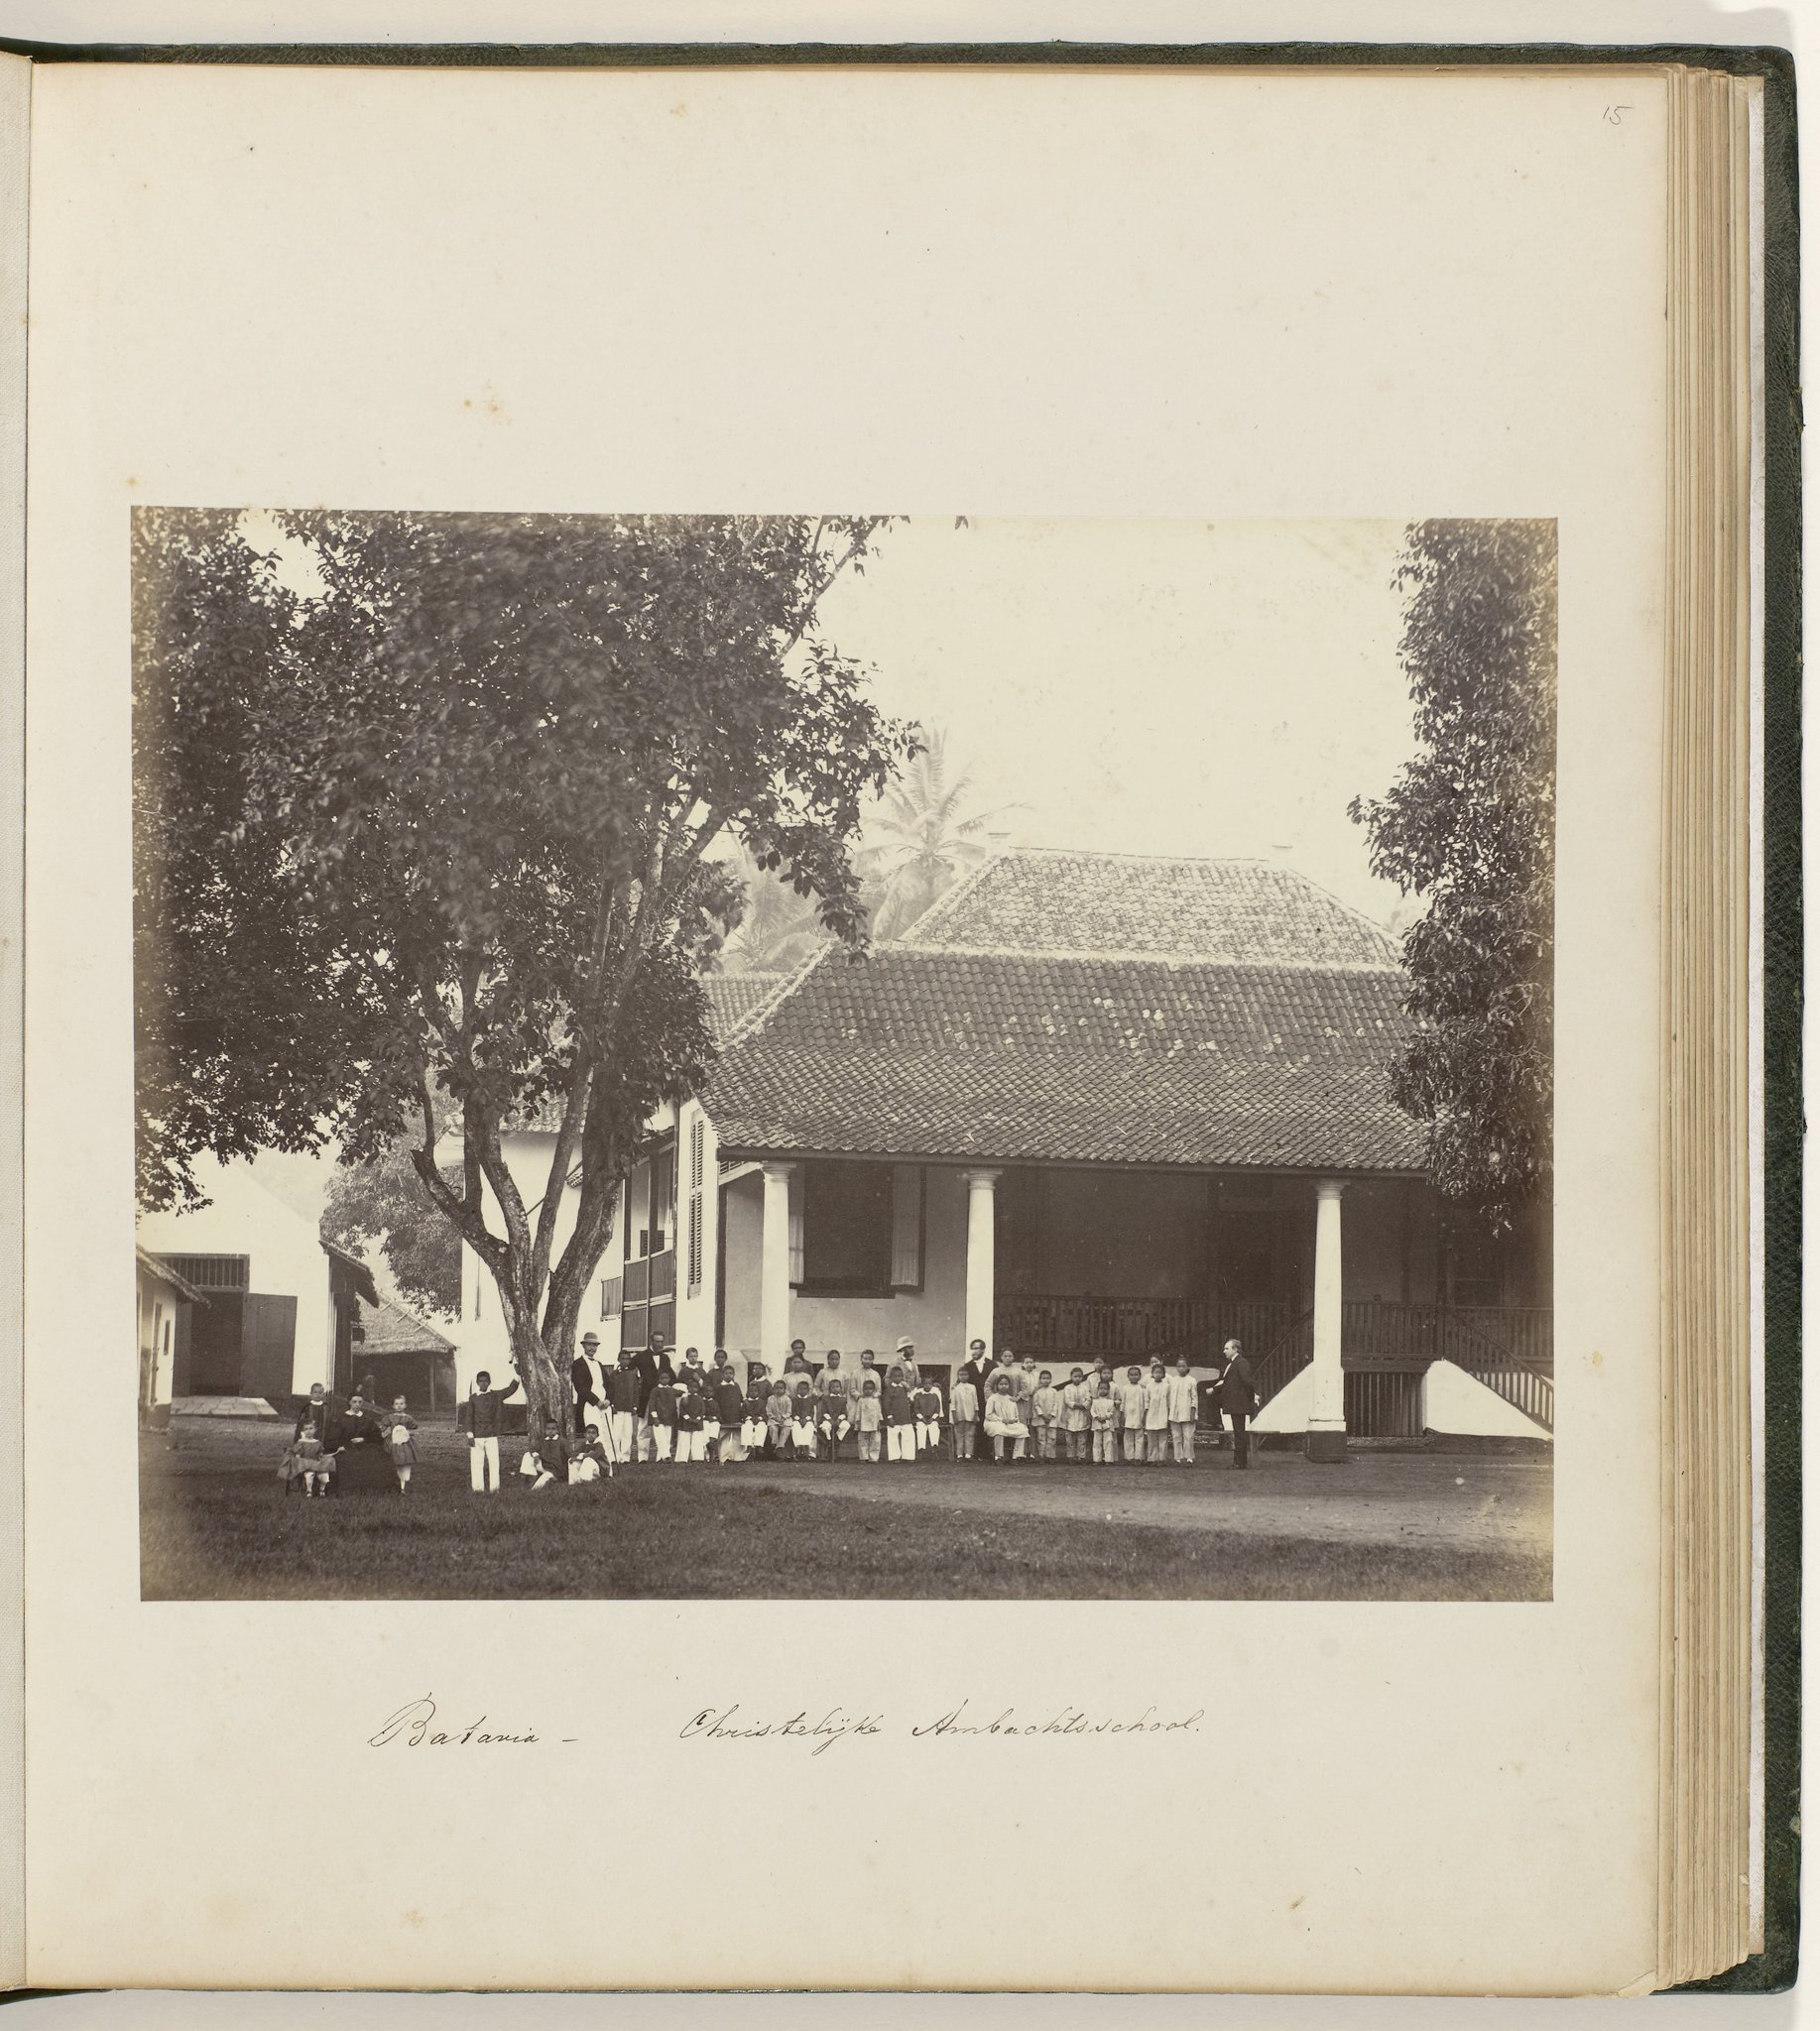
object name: photograph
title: Batavia - Christelijke Ambachtsschool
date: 1863-1866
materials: photographic support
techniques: albumen print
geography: batavia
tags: vocational education, e.g.: junior technical school, batavia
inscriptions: inscription: ‘Batavia - Christelijke Ambachtsschool’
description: Personeel en leerlingen van de Christelijke Ambachtsschool poseren voor het schoolgebouw te Batavia. Onderdeel van het tweede groene fotoalbum met foto's van Java, uit het bezit van apotheker Specht-Grijp, die in 1865 vanuit Batavia naar Nederland terugkeerde.